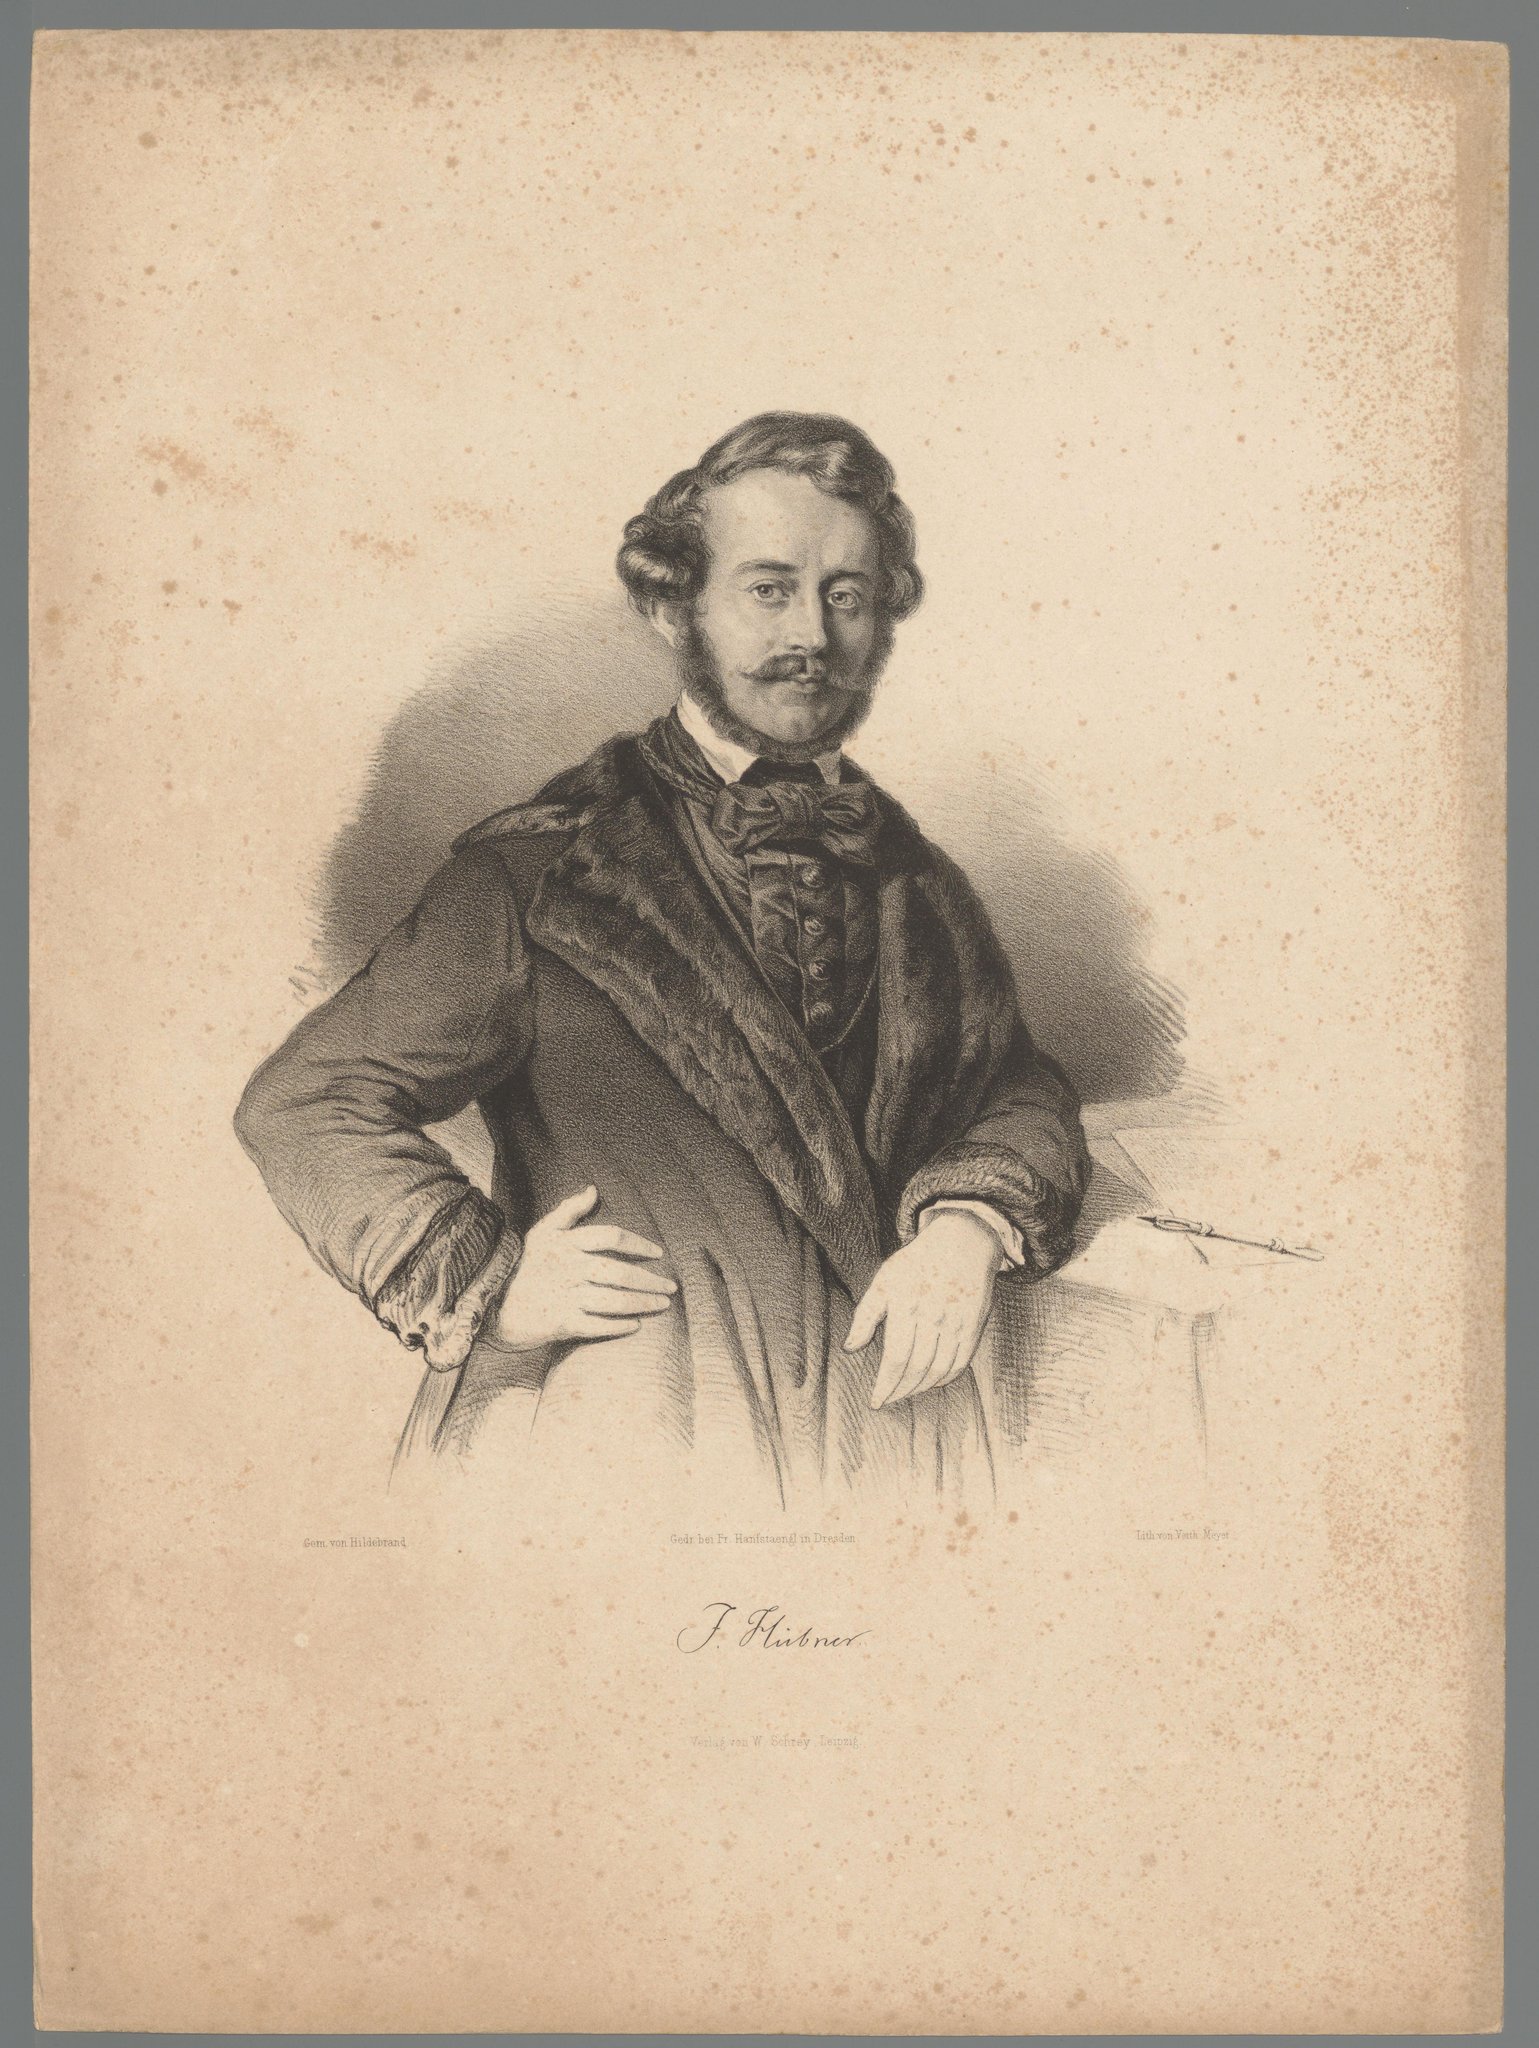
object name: print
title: Portret van Julius Hübner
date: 1830-1875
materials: paper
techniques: lithograph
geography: dresden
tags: painter, julius hübner, adult man, historical persons, writing accessories, beard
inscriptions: collector's mark: Lugt 2228